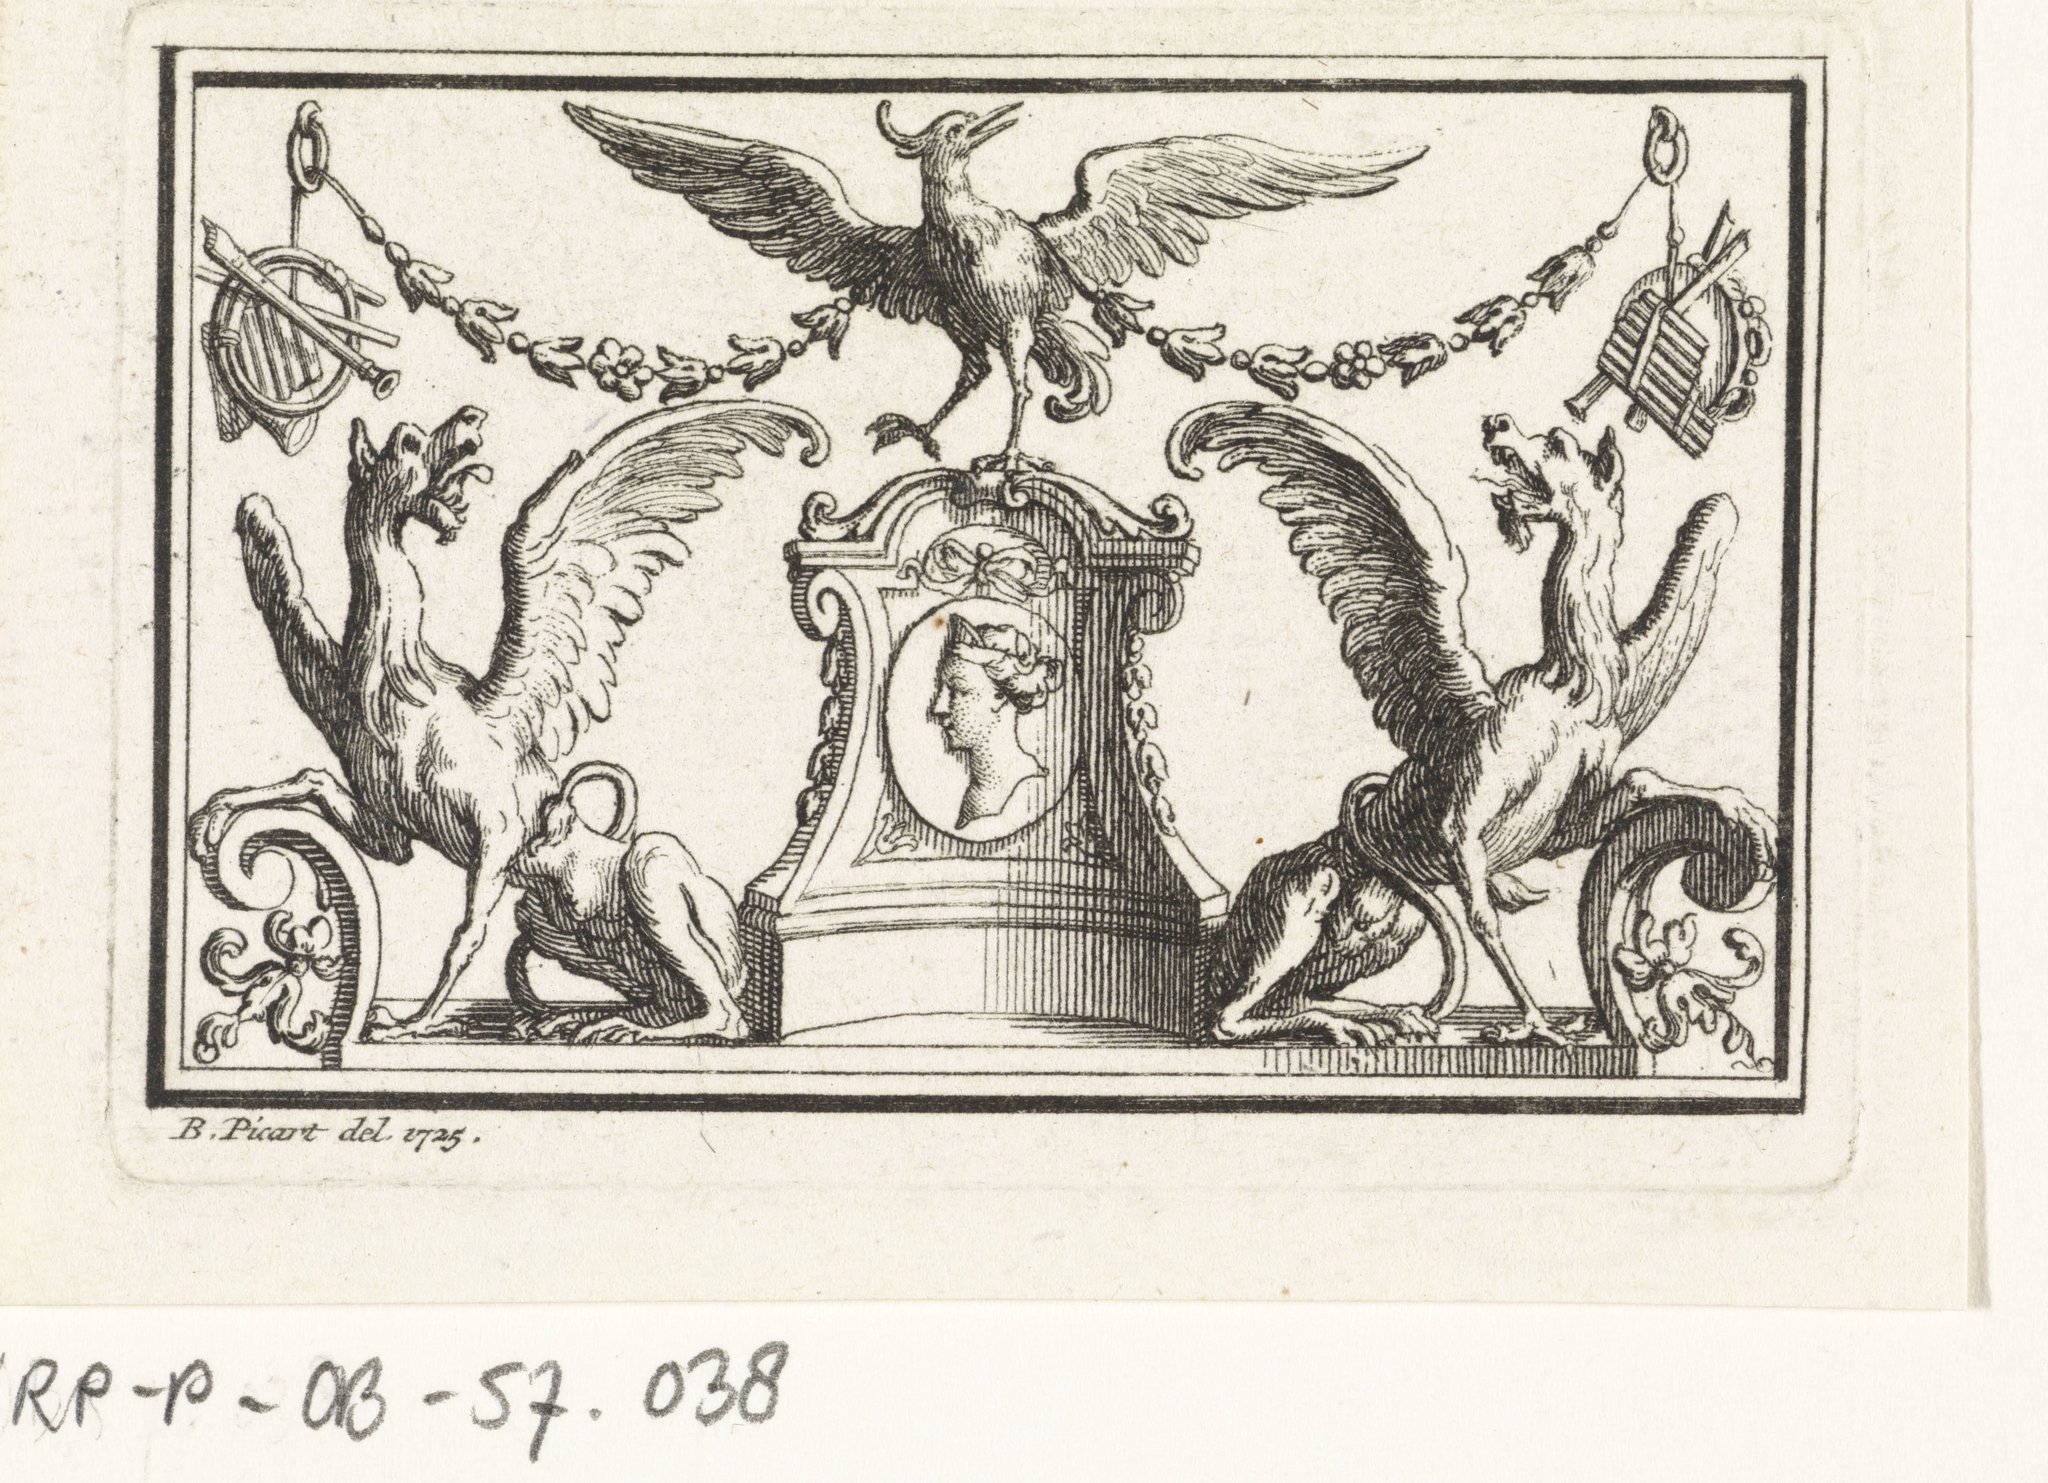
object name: print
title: Vogel op een ornamenteel monument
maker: bernard picart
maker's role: draughtsman, print maker, publisher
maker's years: 1673-1733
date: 1725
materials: paper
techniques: engraving, etching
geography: amsterdam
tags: musical instruments; group of musical instruments, ornament ~ hybrid beings; human and animal forms mixed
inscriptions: collector's mark: Lugt 240